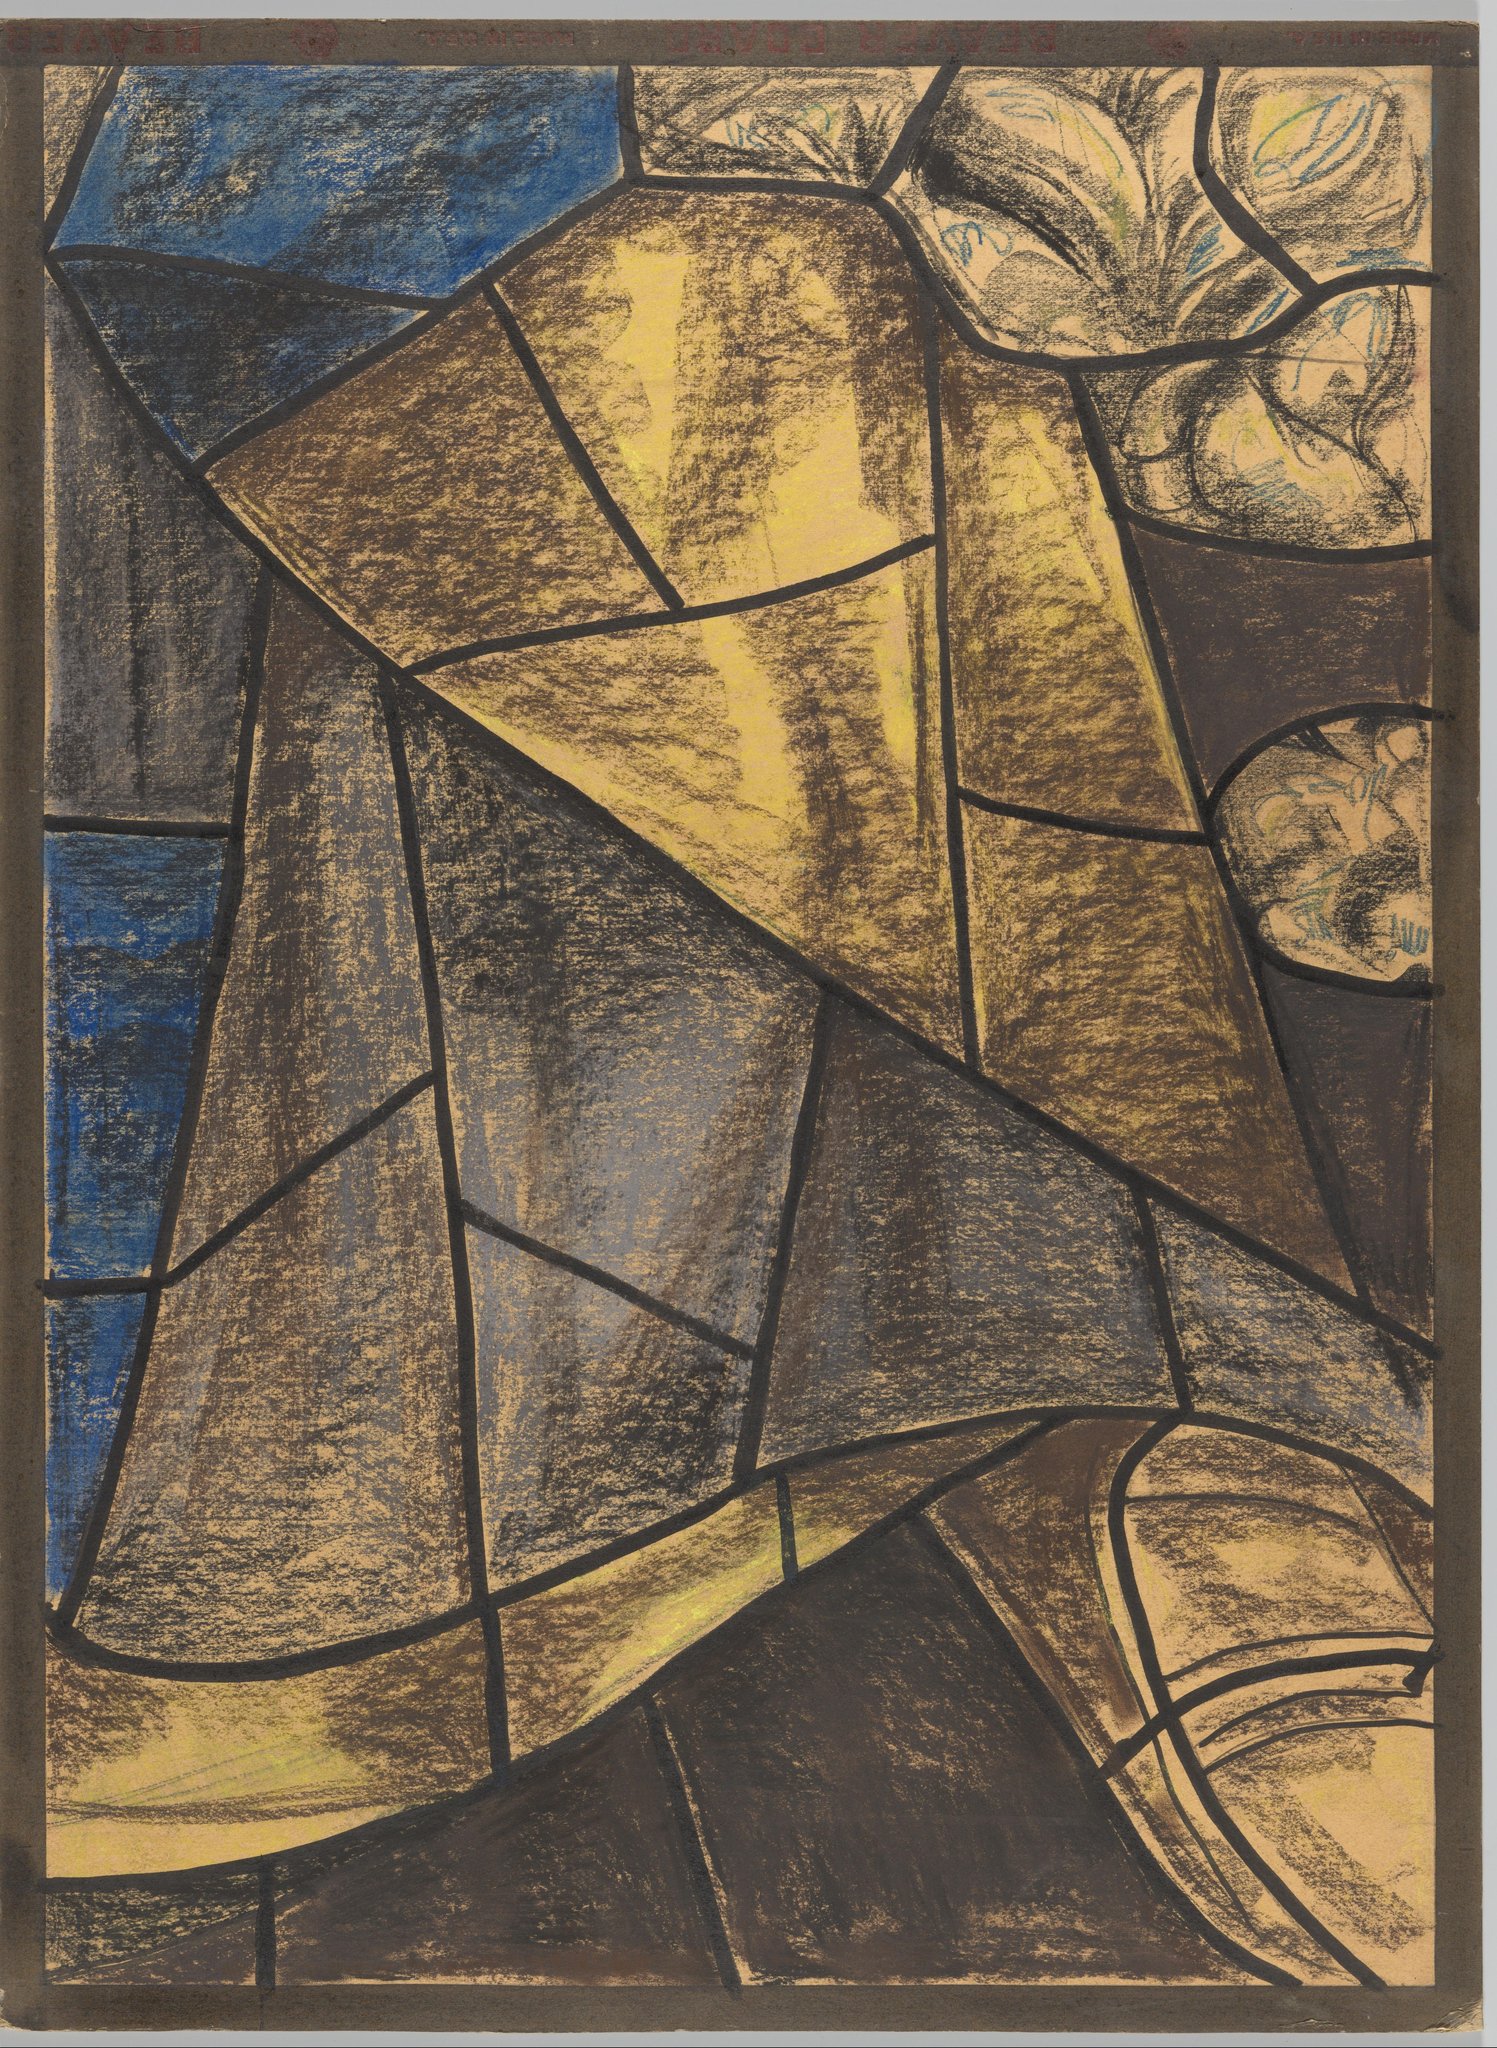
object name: design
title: Ontwerp voor raam in het Noordertransept in de Dom te Utrecht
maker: richard nicolaüs roland holst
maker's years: 1868-1938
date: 1934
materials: cardboard, chalk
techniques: brush